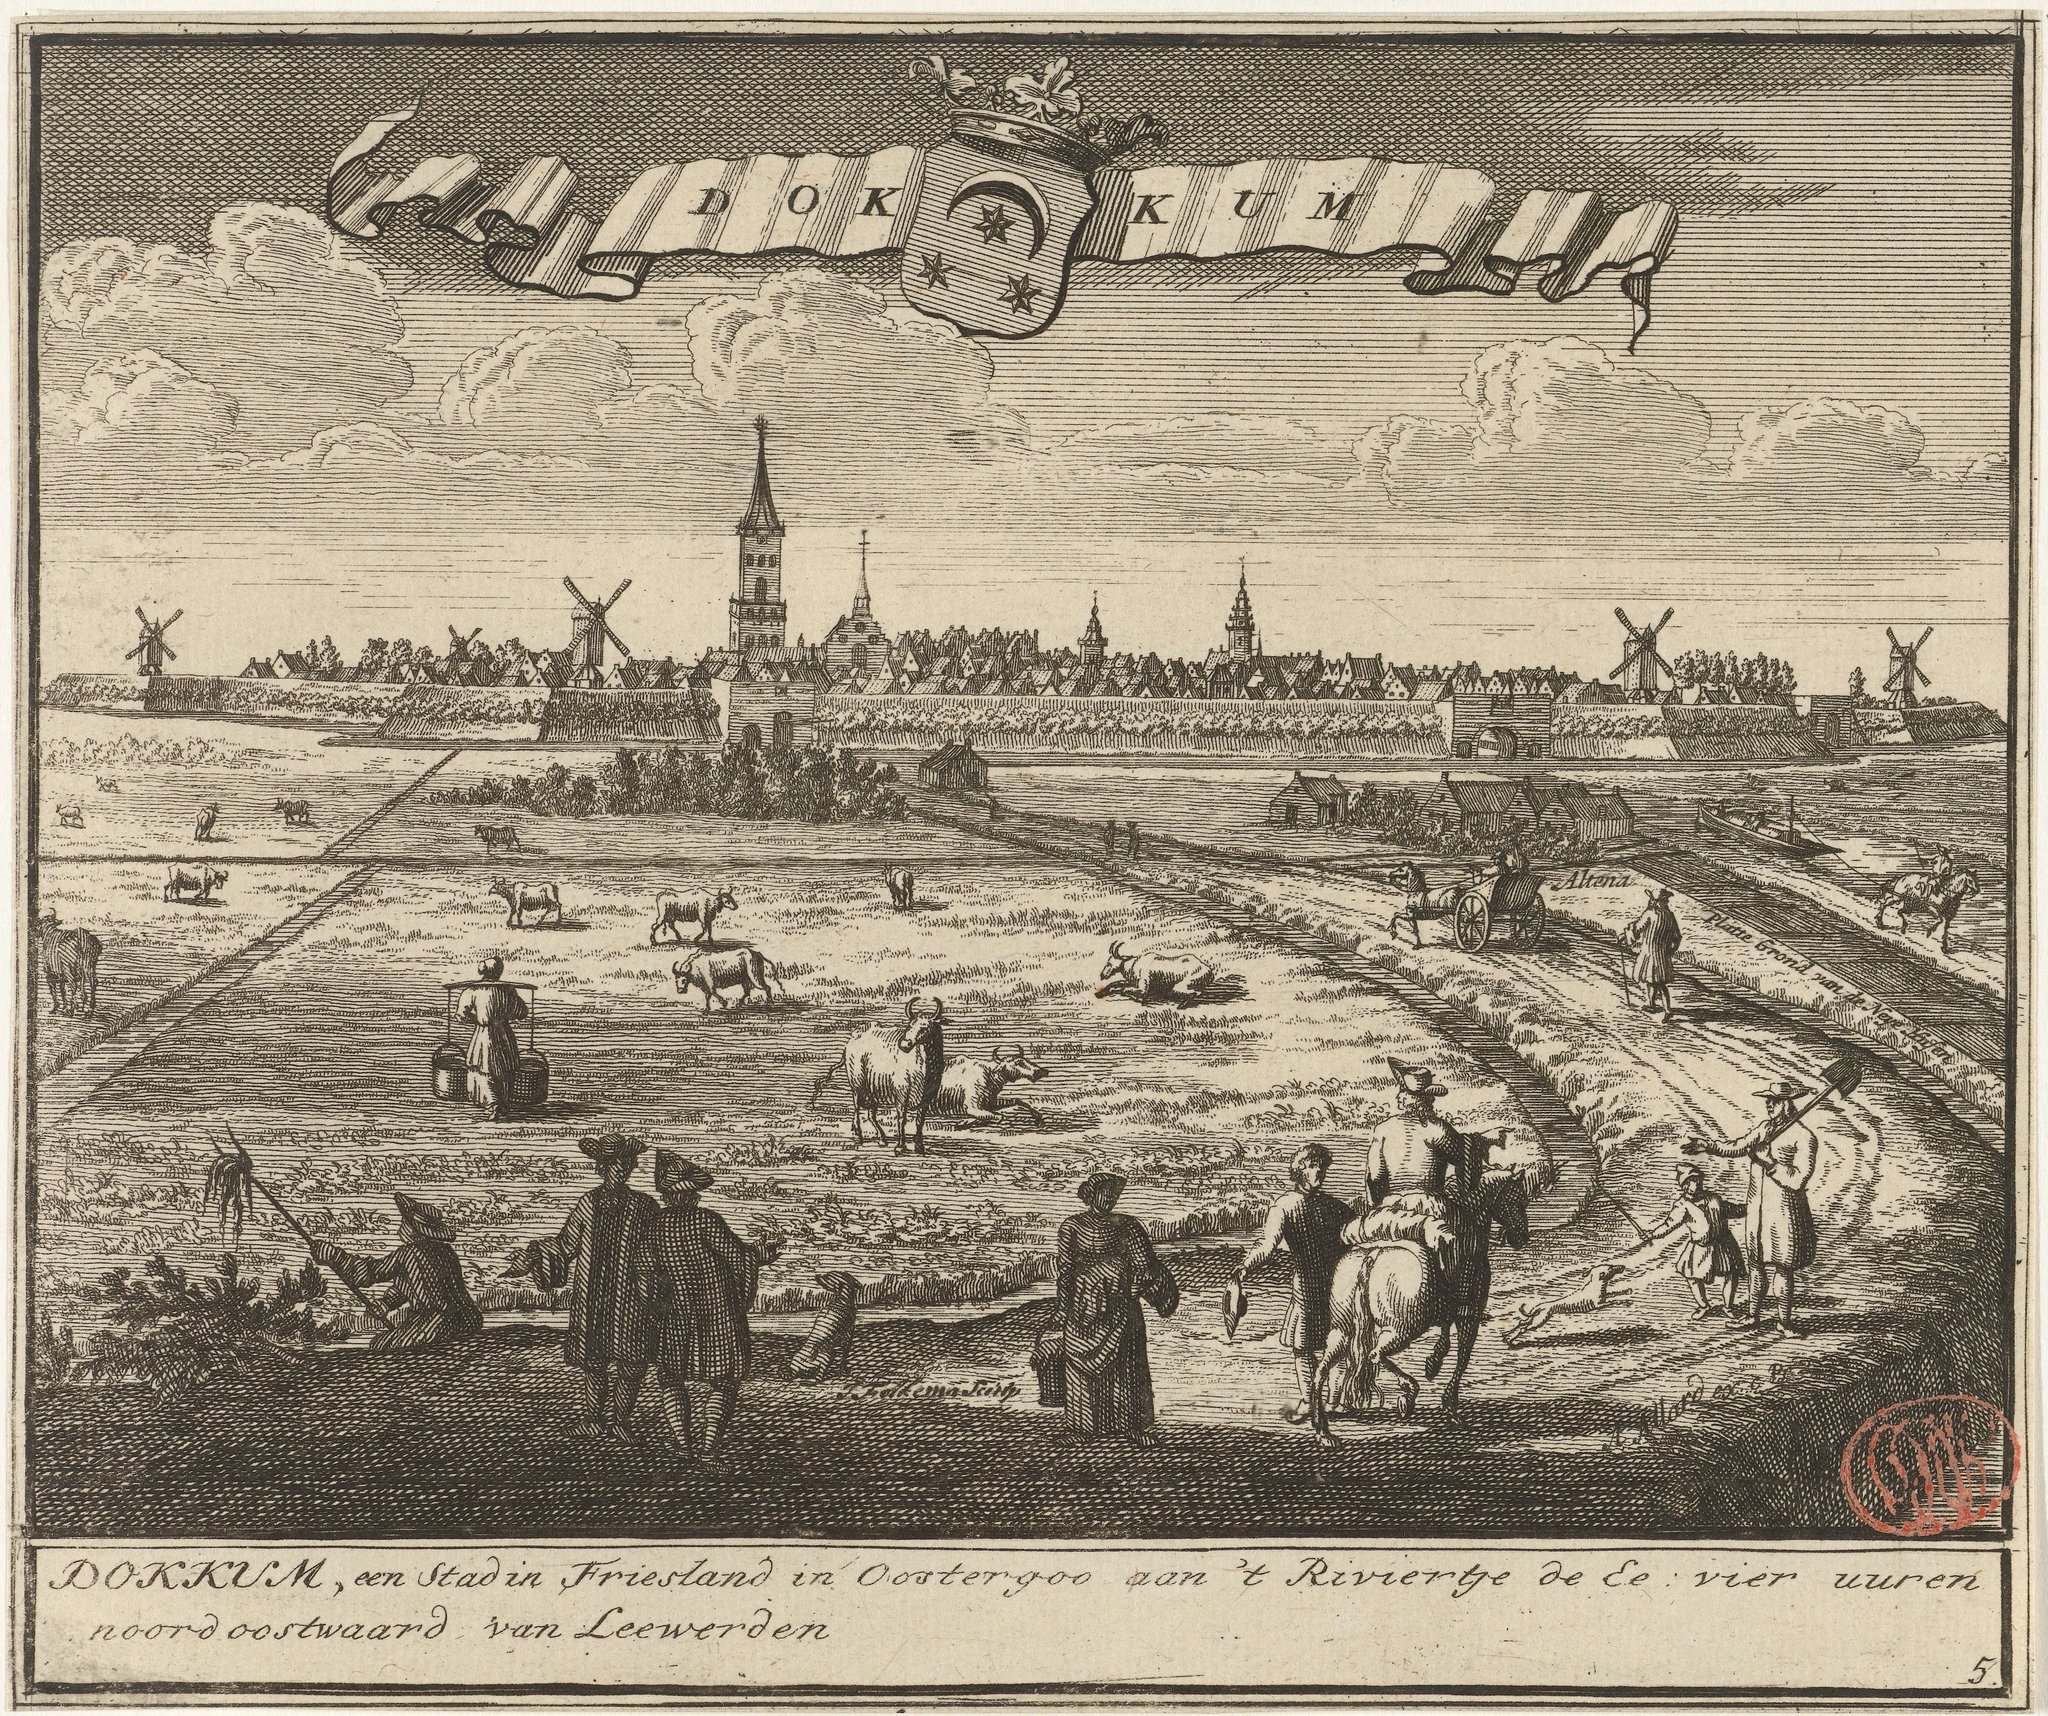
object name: print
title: Gezicht op Dokkum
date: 1702-1725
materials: paper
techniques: etching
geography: amsterdam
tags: city-view, and landscape with man-made constructions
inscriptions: collector's mark: Lugt 195, collector's mark: Lugt 2228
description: Gezicht op de stad Dokkum waarboven een banderol met de naam en het wapen van de stad prijkt. In de marge staan twee regels tekst in het Nederlands, geheel rechtsonder gemerkt: 5. De prent maakt deel uit van een serie prenten met stadsgezichten op diverse steden in Friesland.